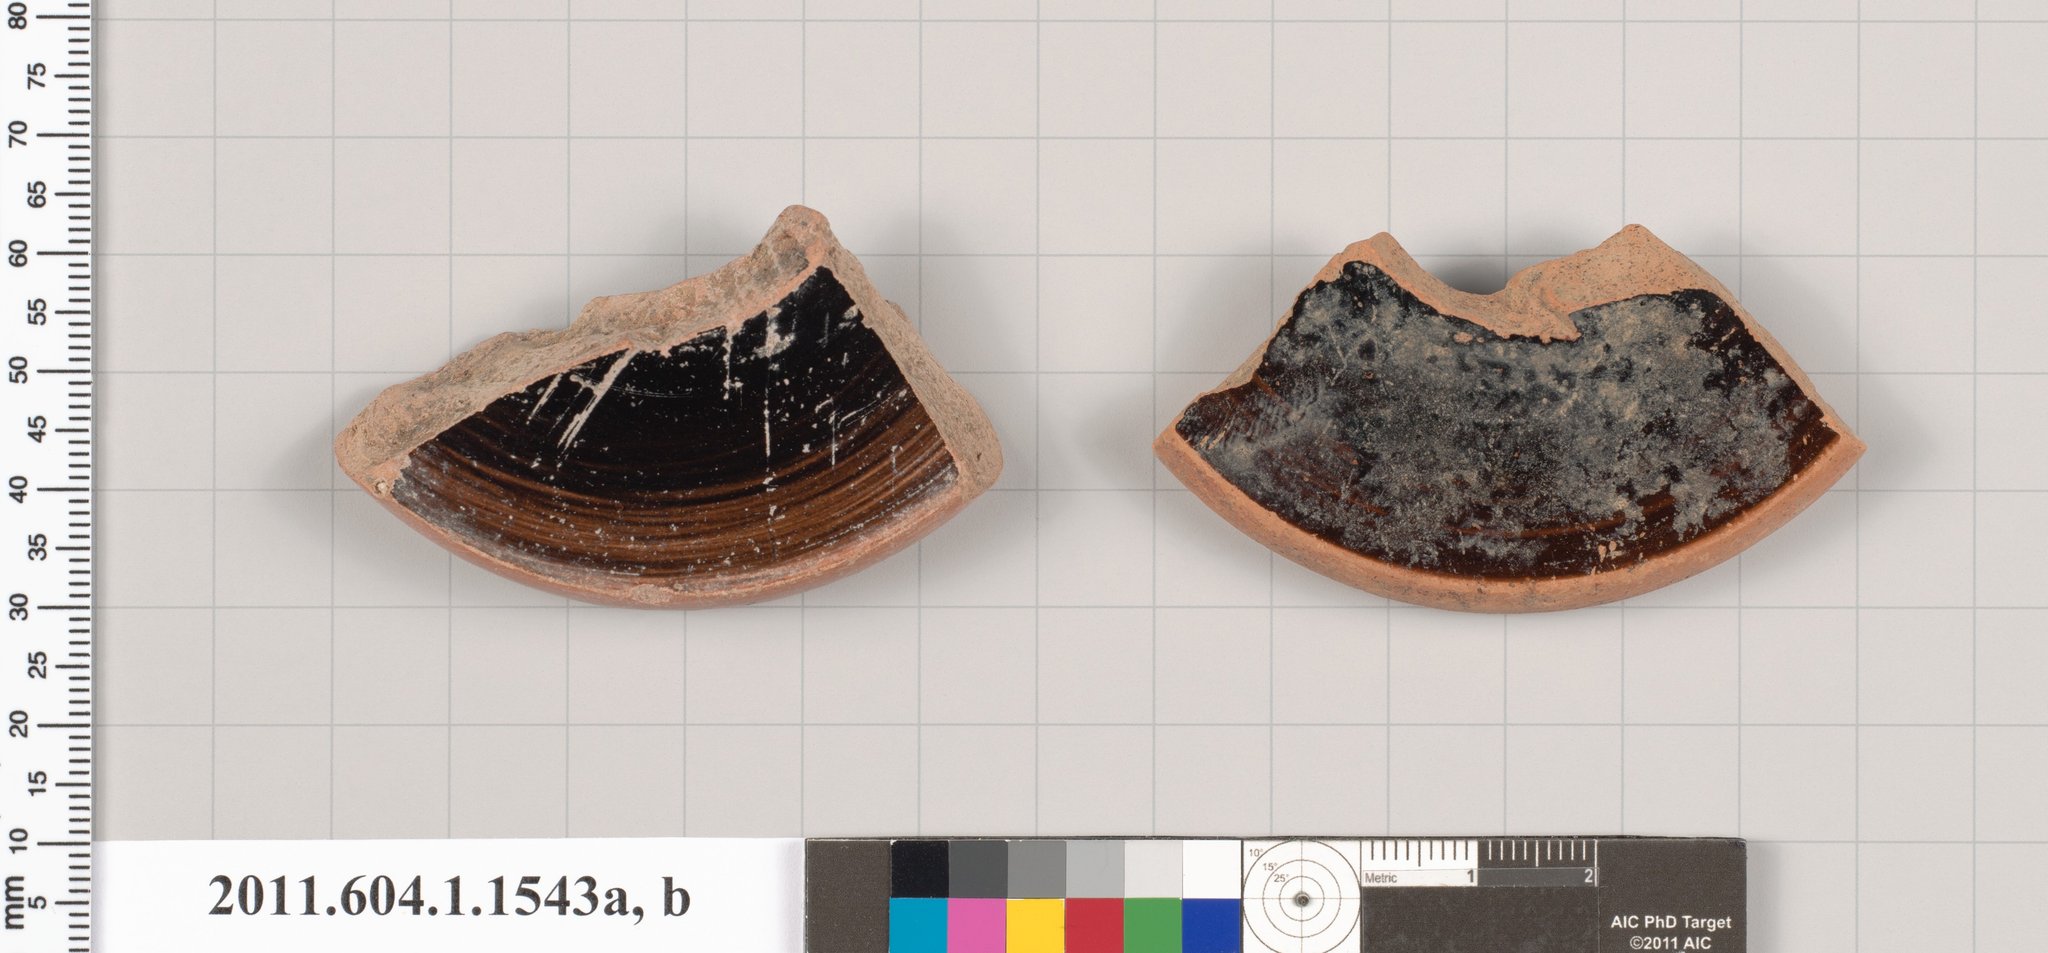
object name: kylix fragment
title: Terracotta fragments of kylikes (drinking cups)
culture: greek, attic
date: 500-401 BCE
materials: terracotta